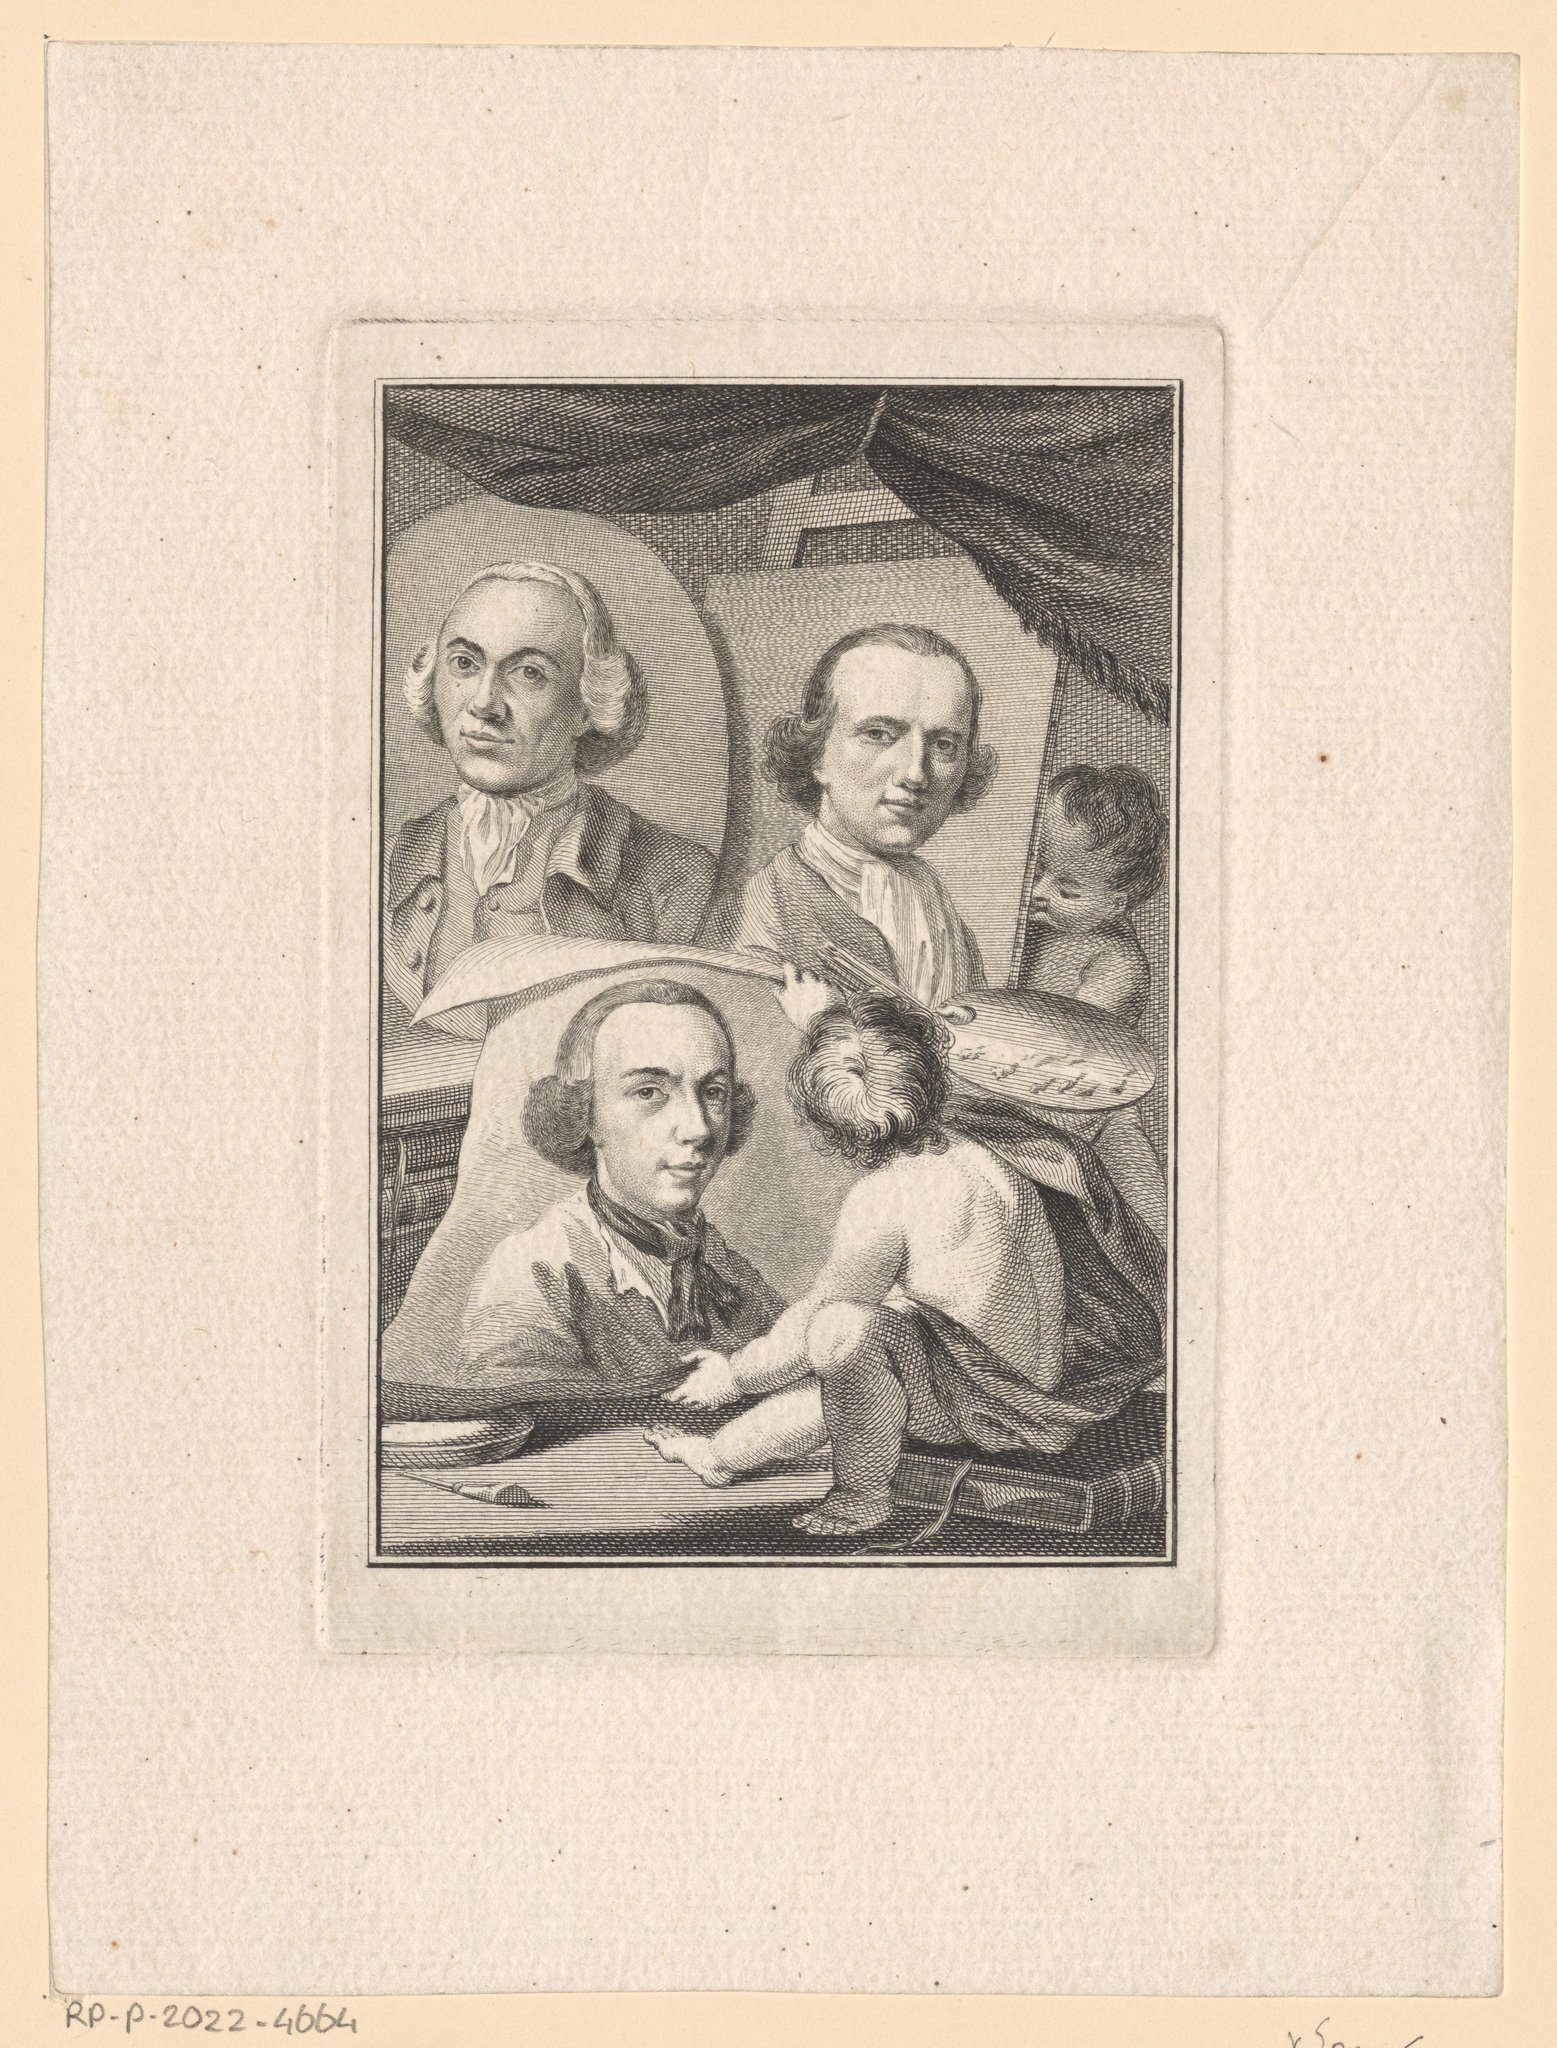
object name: print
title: Portretten van Izaak Schmidt, Jurriaan Andriessen en Reinier Vinkeles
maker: reinier vinkeles (i)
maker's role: draughtsman, print maker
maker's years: 1741-1816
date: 1765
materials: paper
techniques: engraving, etching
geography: amsterdam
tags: amsterdam, painter, draughtsman, jurriaan andriessen, print maker, izaak schmidt, reinier vinkeles (i), drawing, historical persons, portrait, self-portrait of painter, tools, implements of painter, cupids: 'amores', 'amoretti', 'putti', portrait, self-portrait of graphic artist